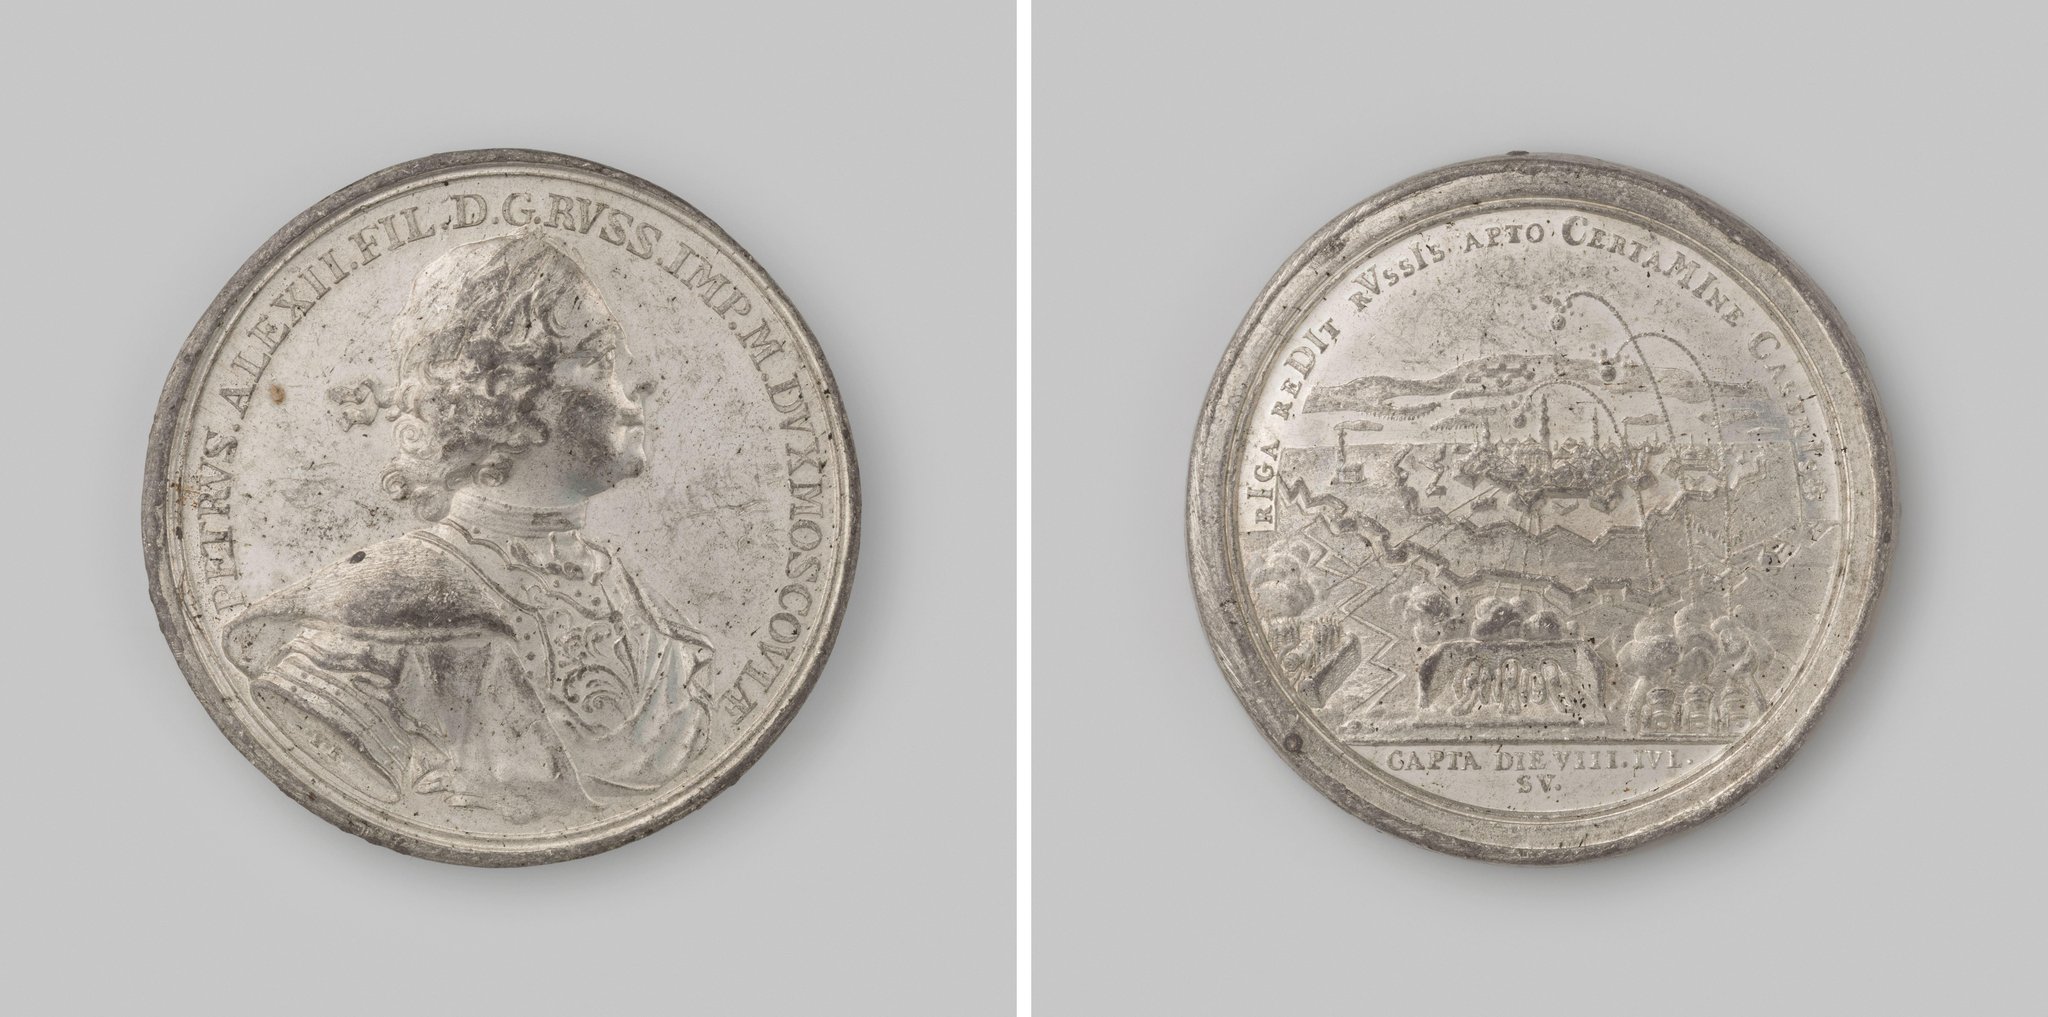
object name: history medal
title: Inname van Riga door Rusland op Zweden 1710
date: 1710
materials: tin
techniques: striking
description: Tinnen penning, op de voorzijde het borstbeeld van Tsaar Peter de Grote naar rechts met omschrift, op de keerzijde het bombardement van Riga, met omschrift en afsnedetekst.